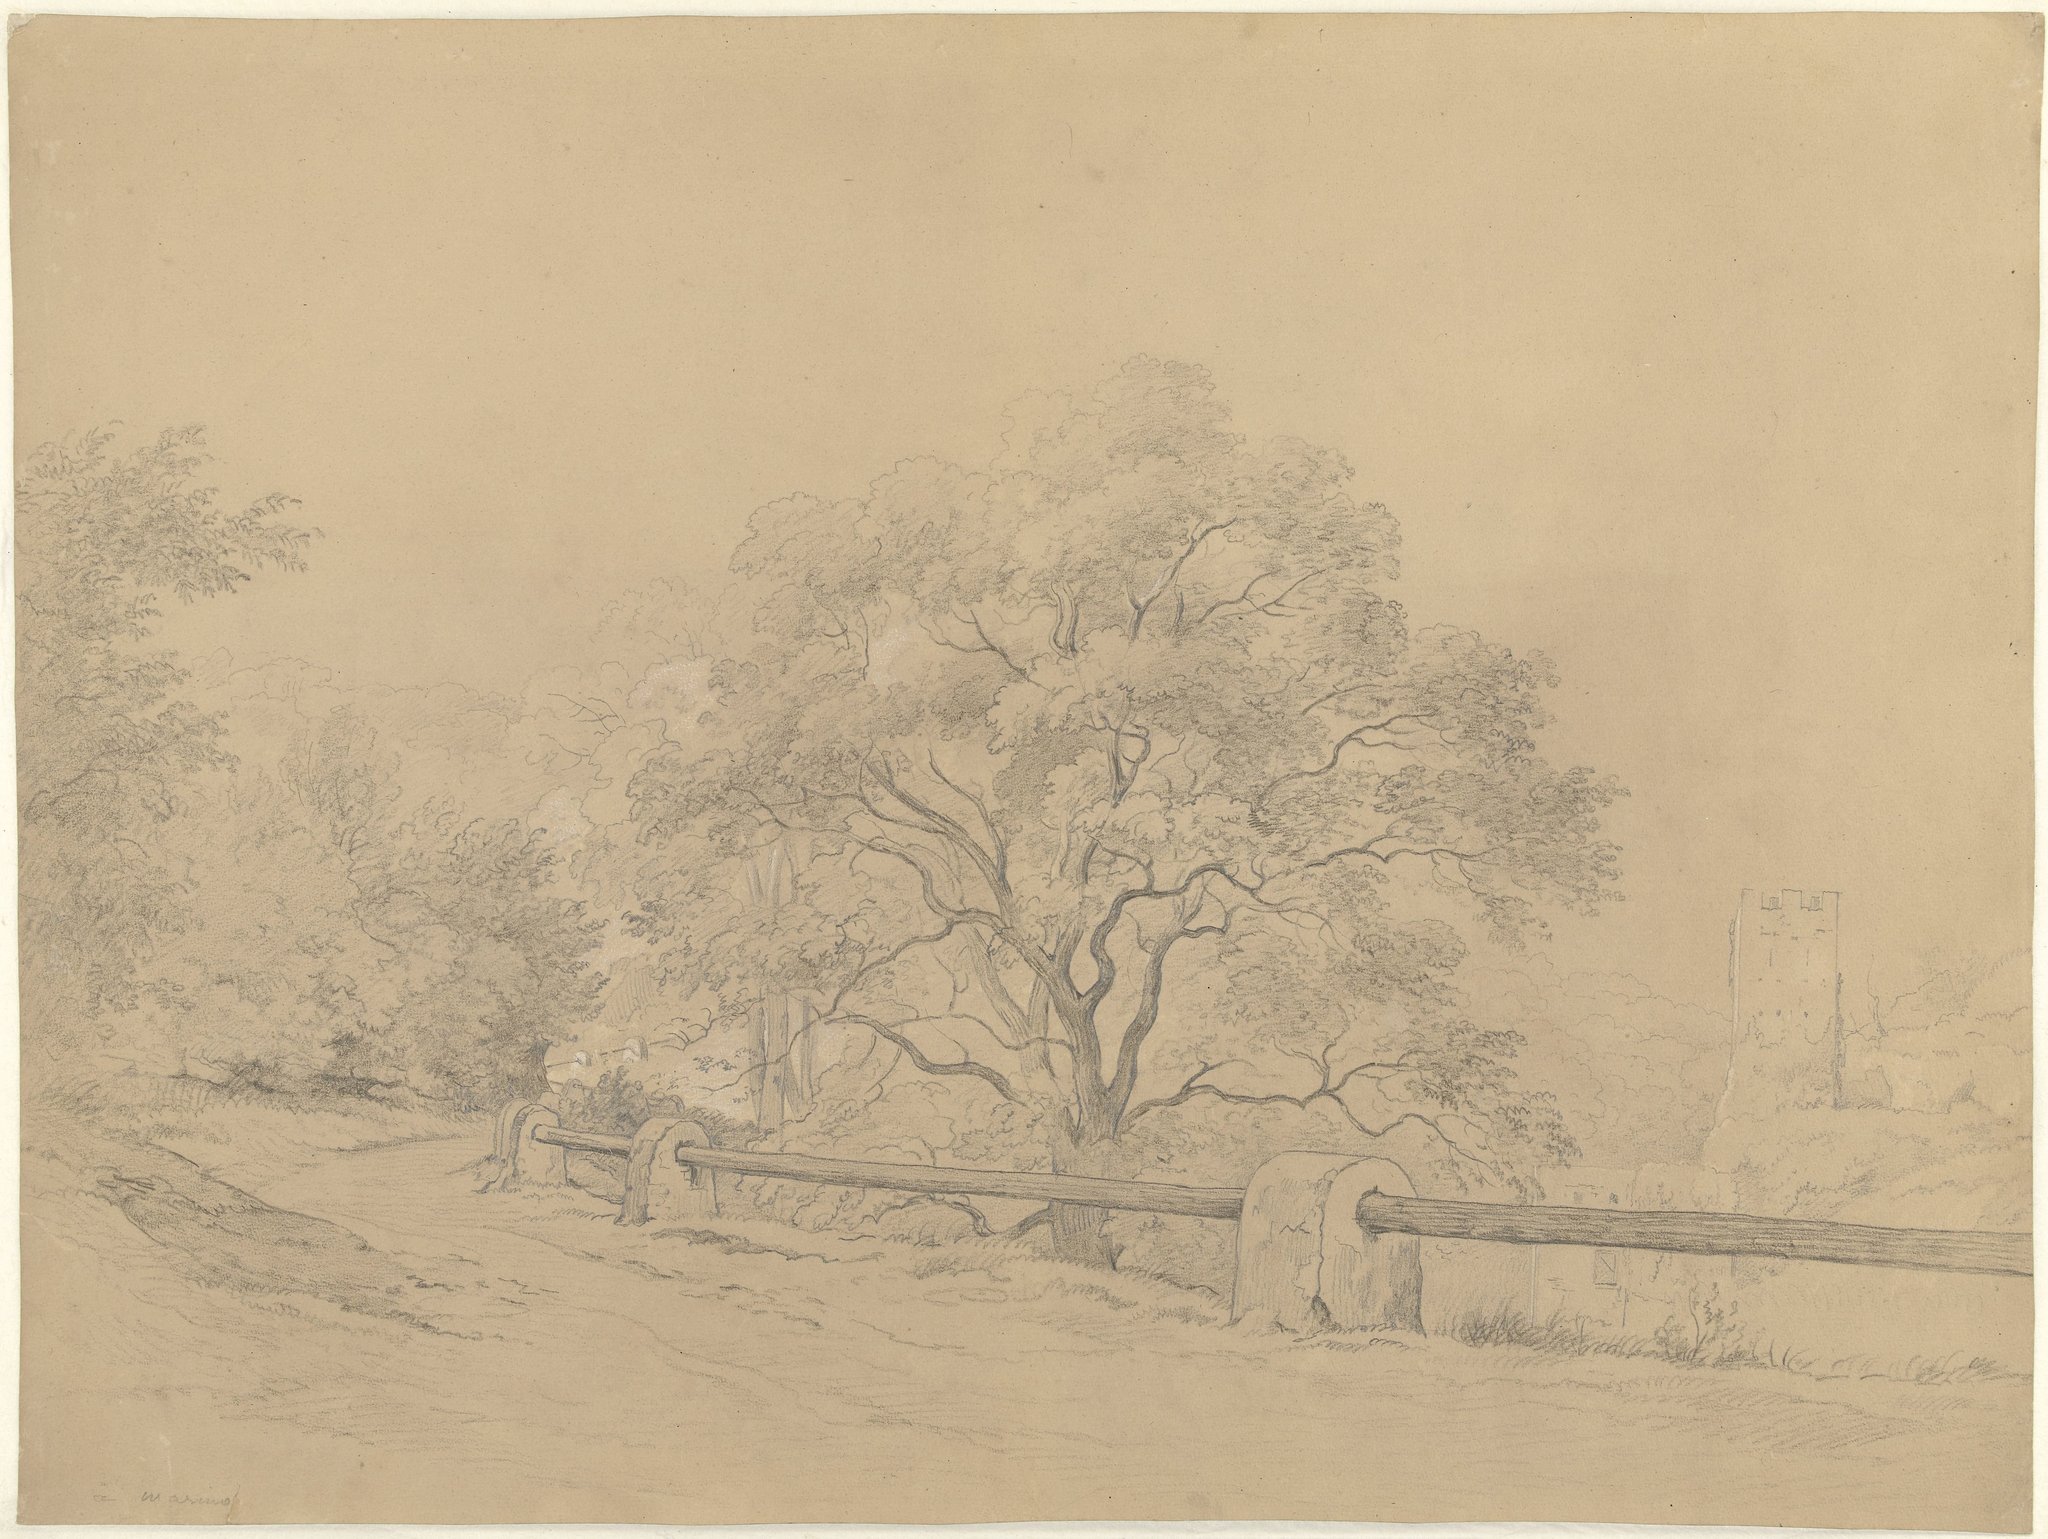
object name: drawing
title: Landschap met weg bij Marino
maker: abraham teerlink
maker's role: draughtsman, painter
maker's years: 1776-1857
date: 1786-1857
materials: chalk, paper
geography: marino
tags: landscapes